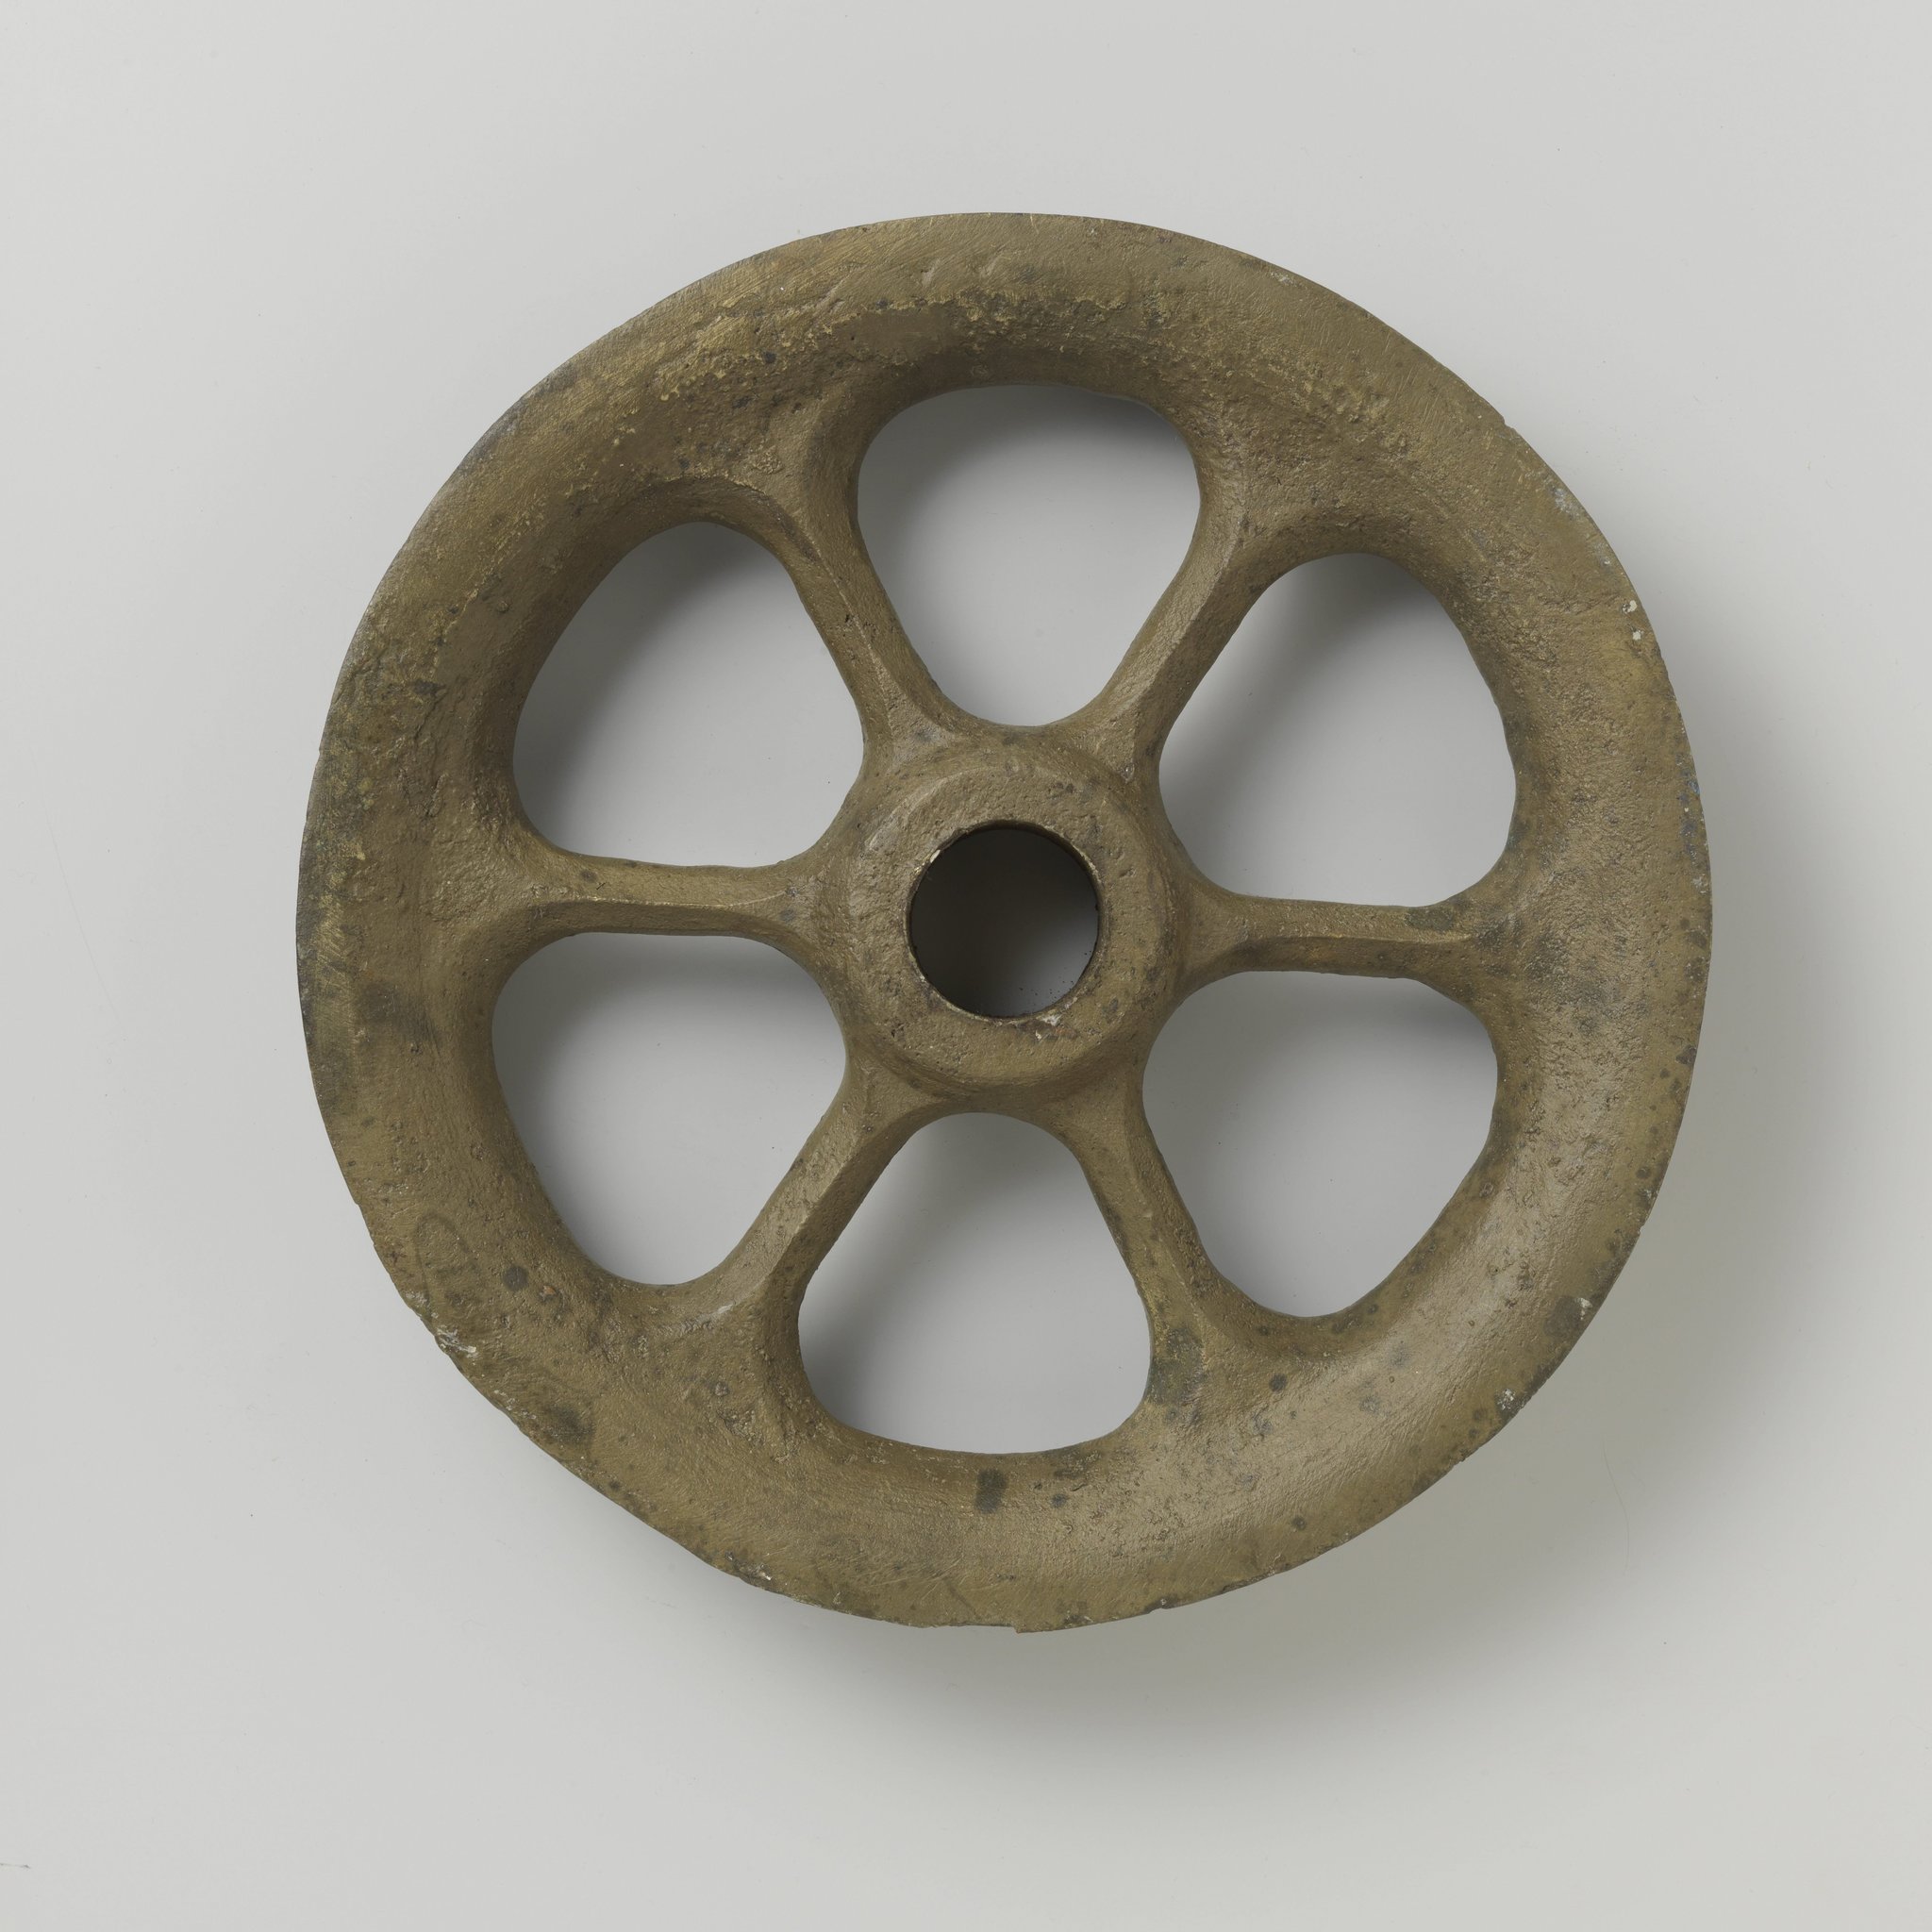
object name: disk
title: Bronzen schijf uit V.O.C.-schip de 'Witte Leeuw'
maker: Anonymous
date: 1613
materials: bronze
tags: verenigde oostindische compagnie, sint-helena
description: Bronzen ronde schijf of rad met in het midden een rond gat en 6 spaken. Vermoedelijk bestemd voor de grote dekknecht en het kardeelblok van de Oost-Indiëvaarder de Witte Leeuw. Met deze zware takel kon de grote ra, waaraan het grootzeil bevestigd was, opgehesen of neergelaten worden.